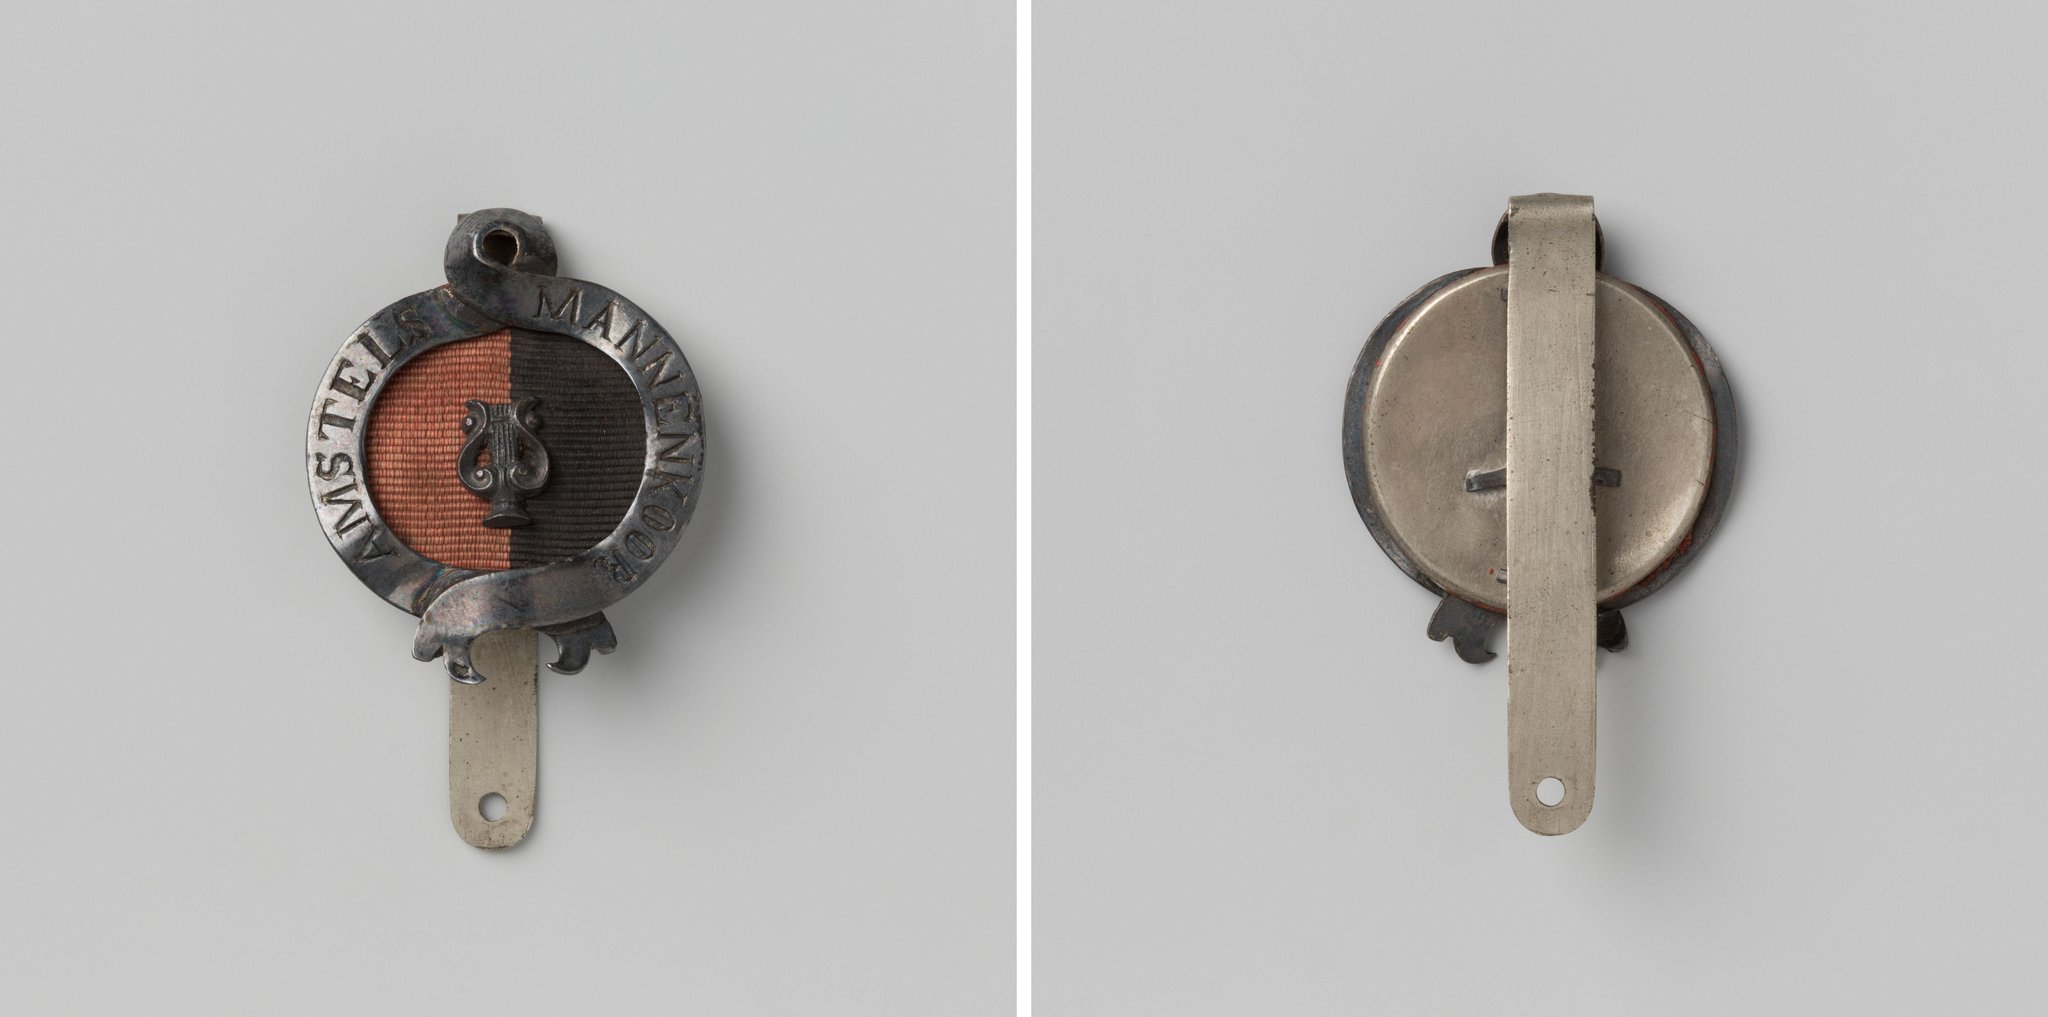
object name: insignia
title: Amstels mannenkoor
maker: Anonymous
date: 1850-1880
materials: silver, textile, tin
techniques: soldering, striking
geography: amsterdam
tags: amsterdam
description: eenzijdig insigne, opgebouwd uit ronde schijf bekleed met lint in verticale, rode en zwarte baan, waarop zijn aan gebracht een harp en een lint met opschrift dat het geheel omringd en dat aan bovenzijde eindigt in lus, waaraan een draagclip is gemonteerd